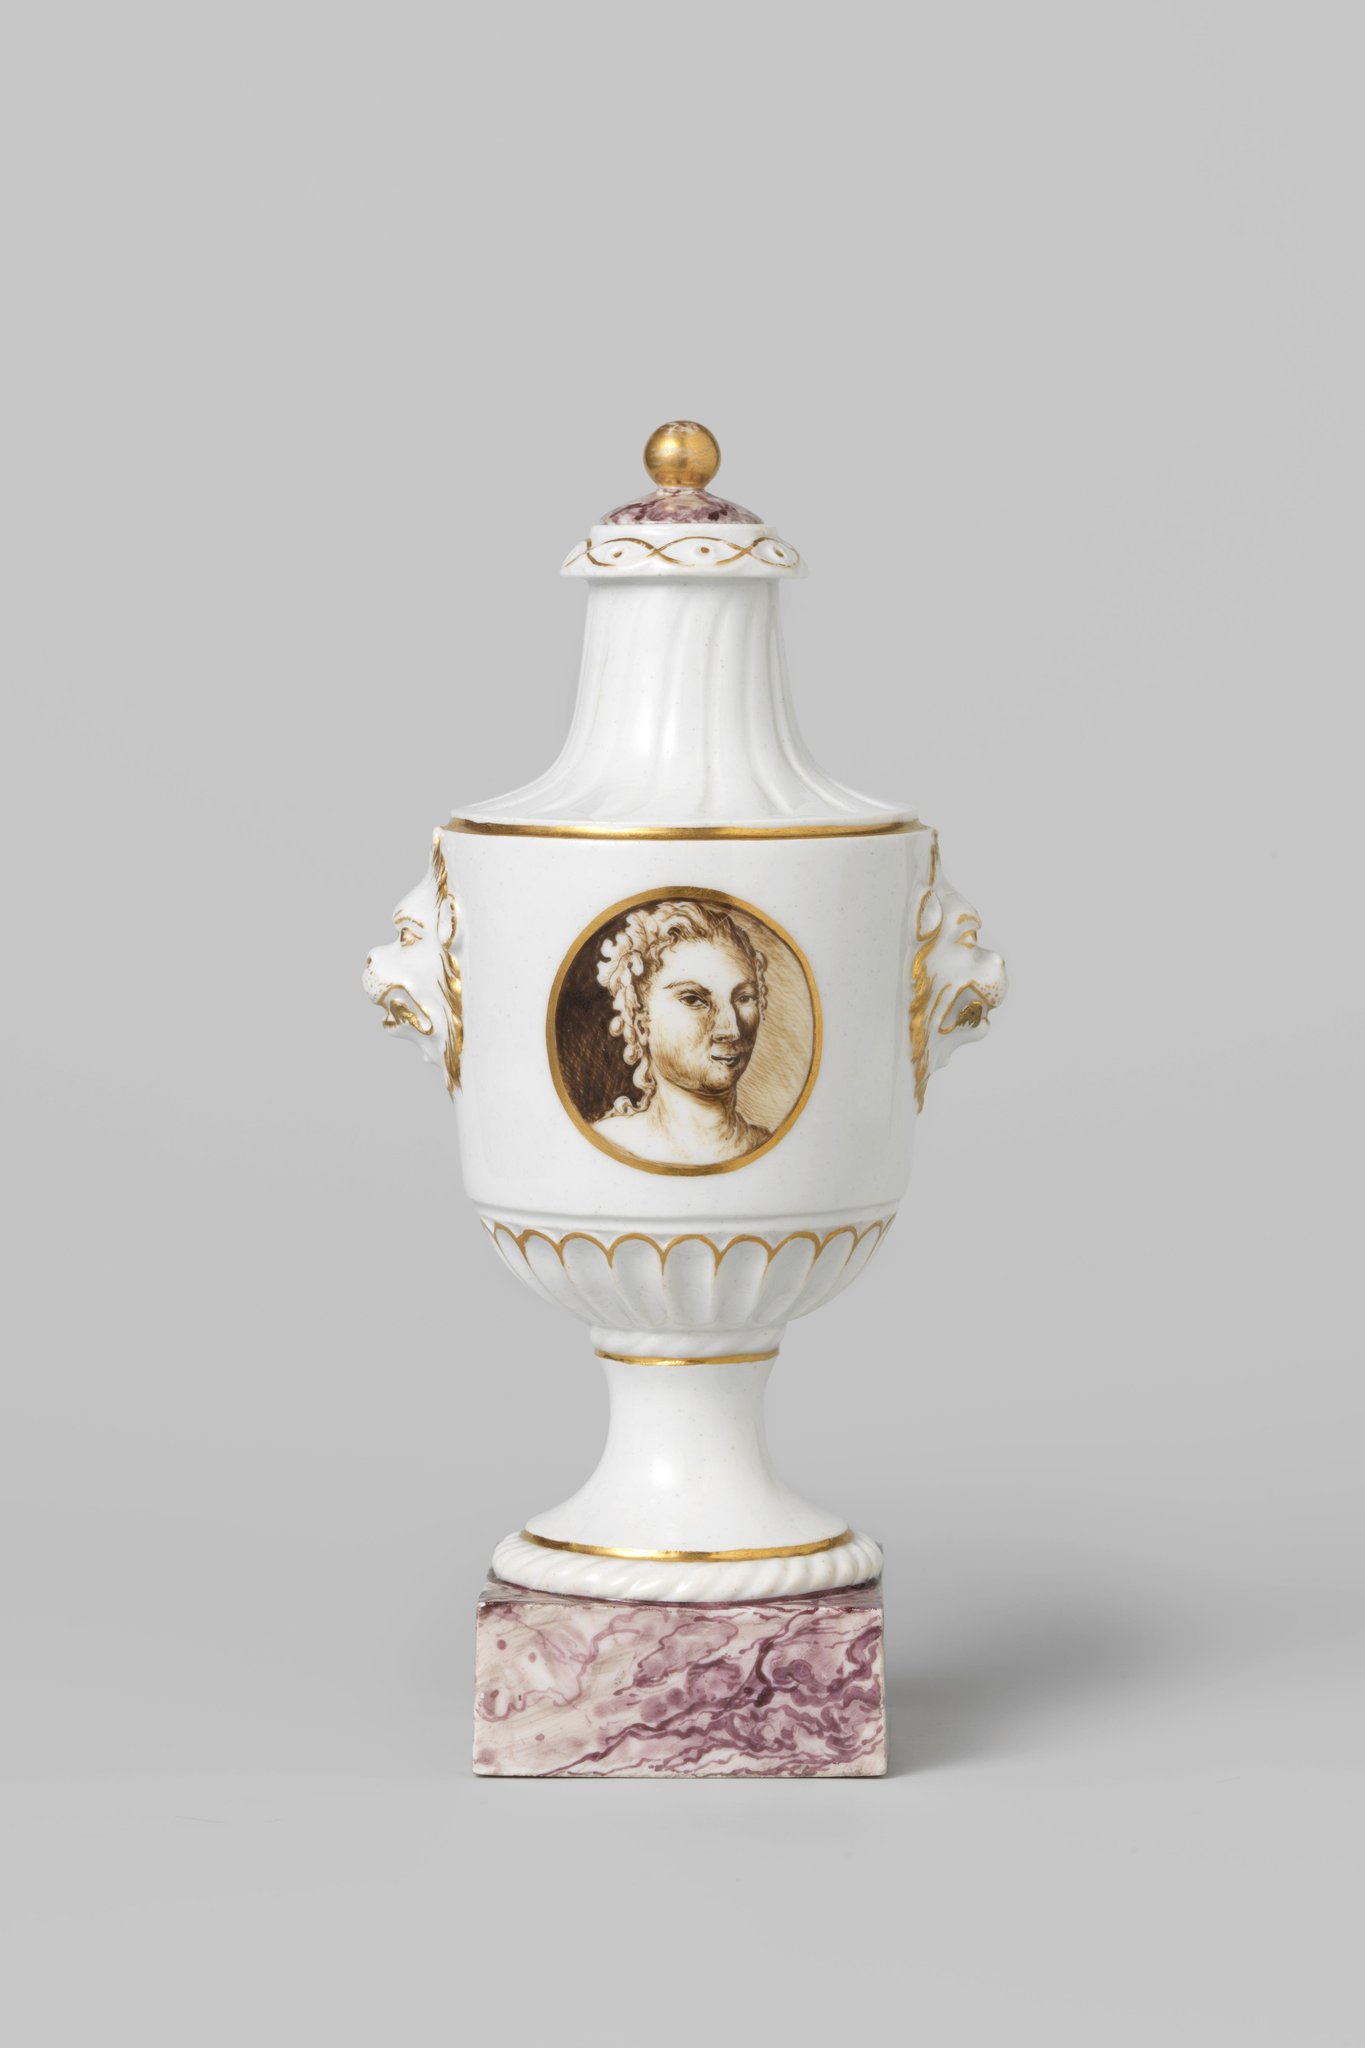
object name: vase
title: Vaas beschilderd met parelhoenders in landschap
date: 1774-1784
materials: porcelain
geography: loosdrecht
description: Vaas van porselein. Op het vierkante voetstuk rust de hoge, ronde voet die de vaas draagt. Op de vaas, leeuwenmaskers als oren. geheel opengewerkt is. Beschilderd met een rivierlandschap met parelhoenders en een kerktoren.